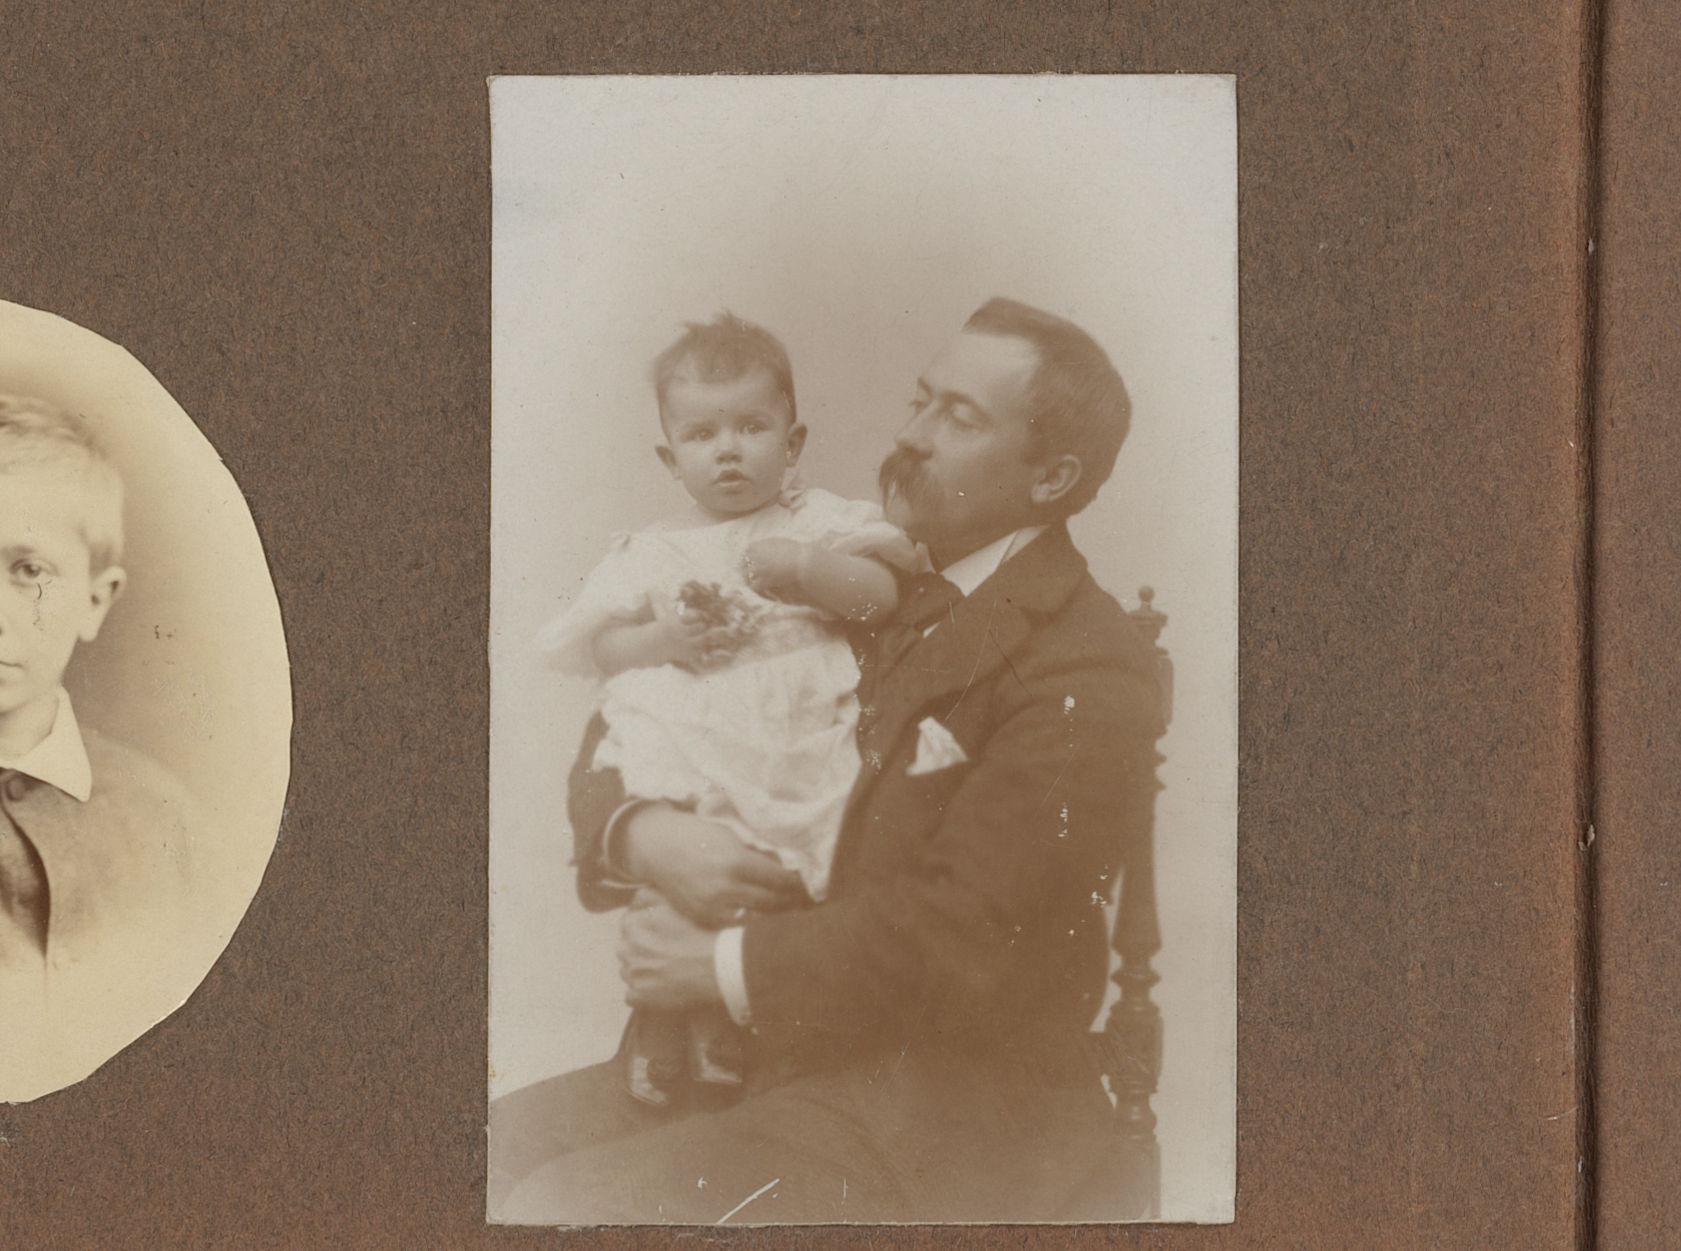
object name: photograph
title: Zittende man met kind op de arm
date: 1870-1910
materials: photographic support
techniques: photography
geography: netherlands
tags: netherlands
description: Foto op bruin albumblad 30 van familiealbum van Alphons Diepenbrock.